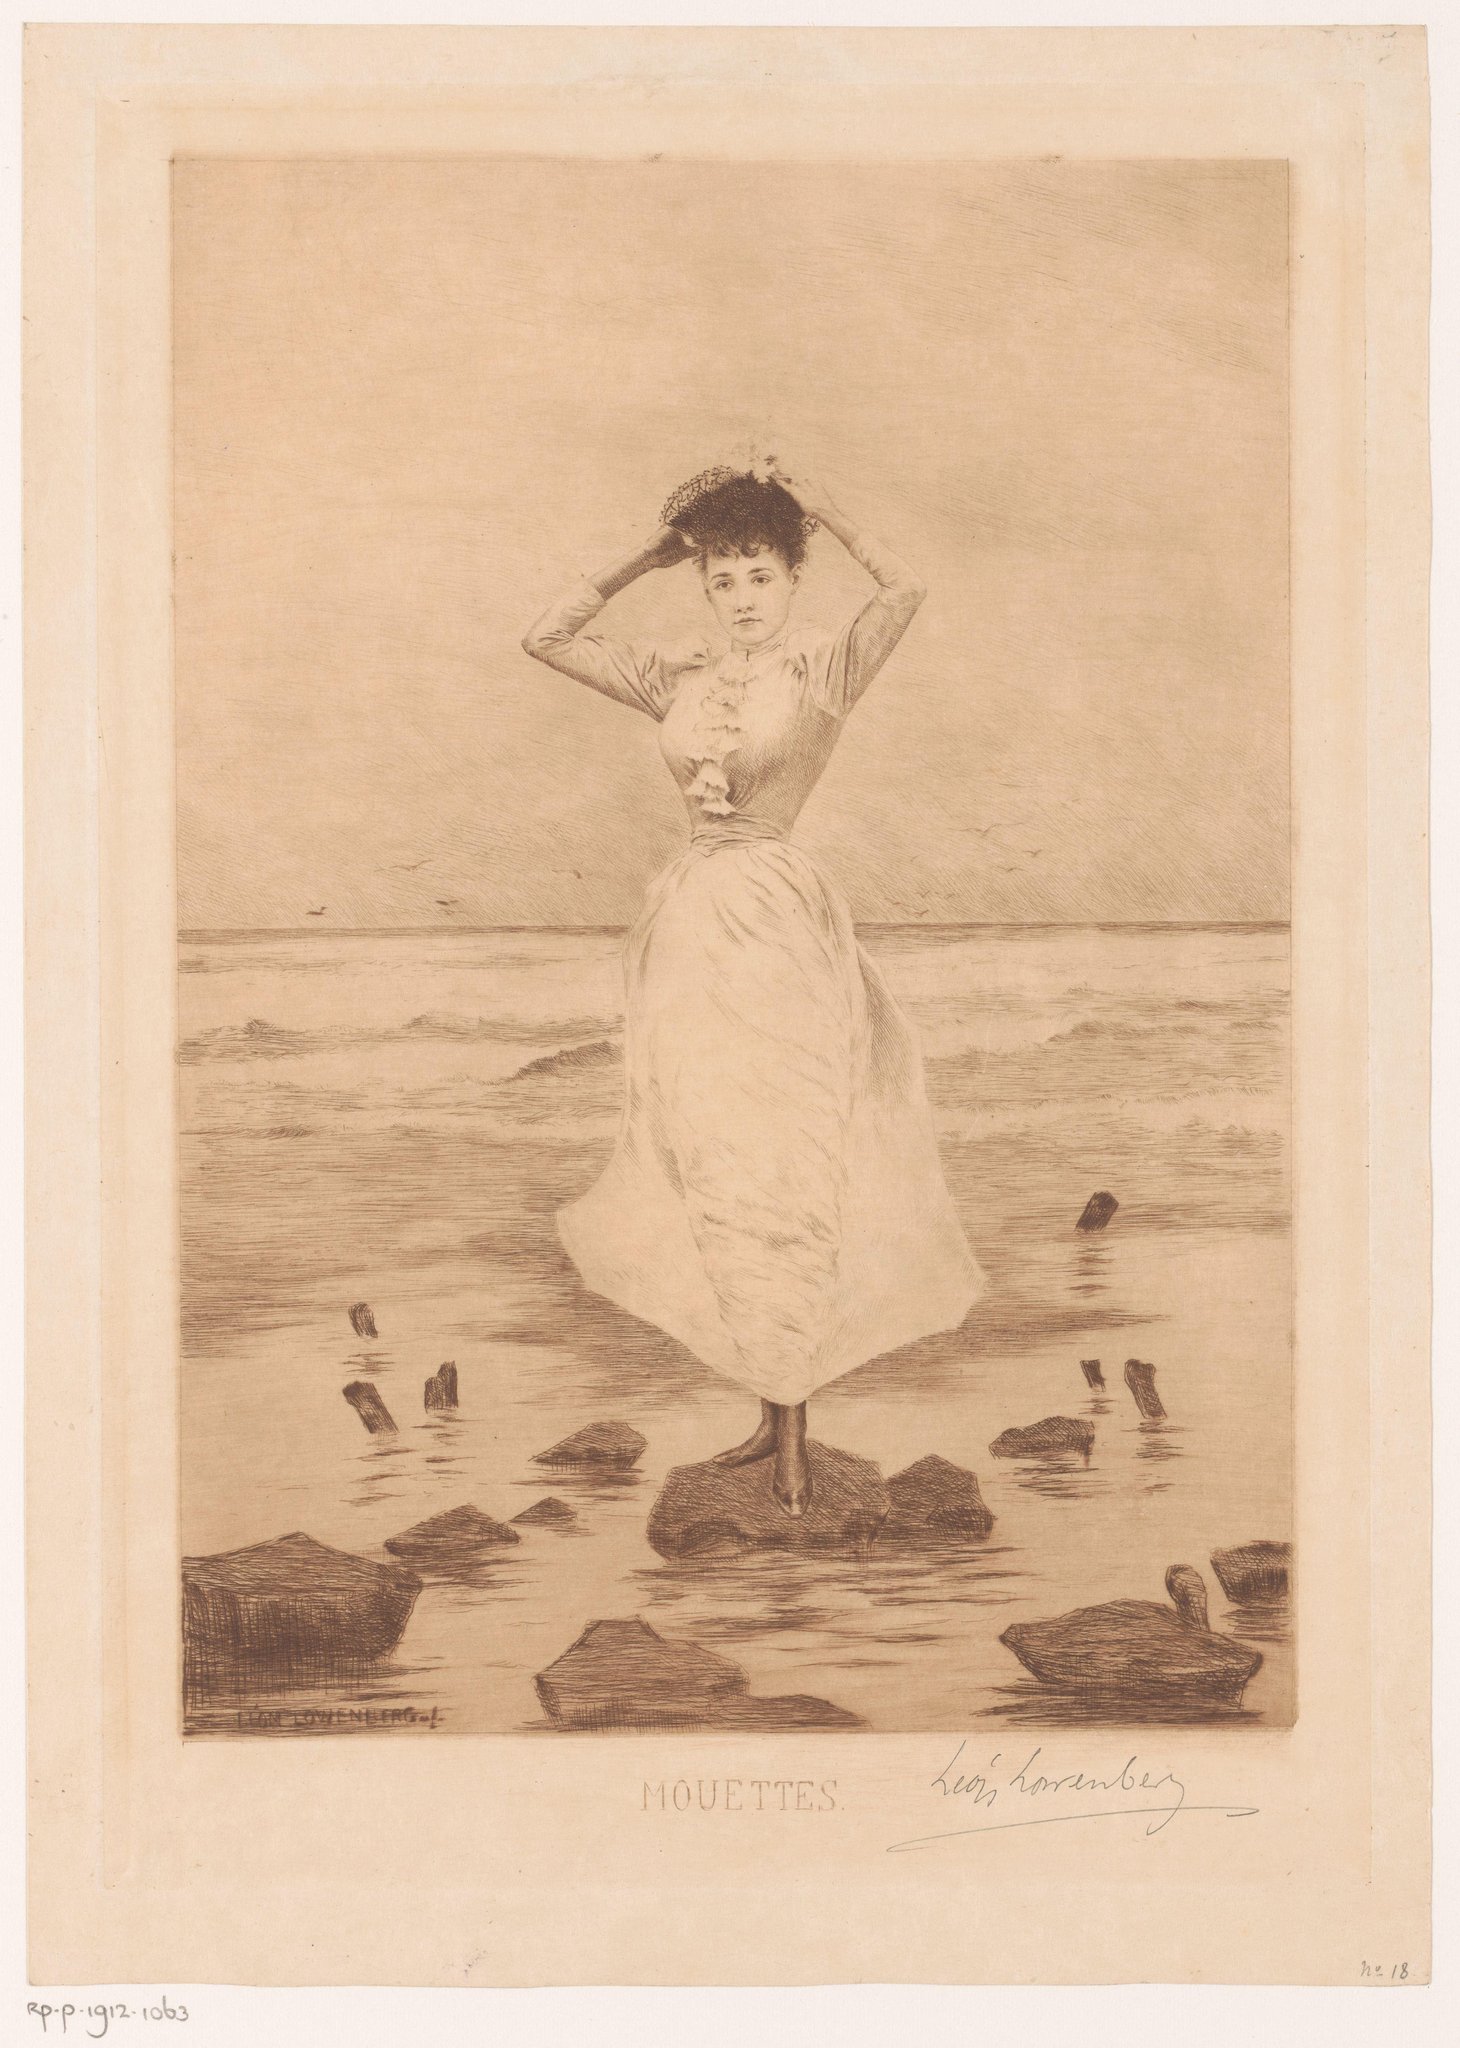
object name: print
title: Mouettes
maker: léon lowenberg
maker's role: print maker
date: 1875-1912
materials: paper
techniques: drypoint, etching, intaglio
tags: surf, breakers (+ landscape with figures, staffage)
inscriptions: collector's mark: Lugt 2228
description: Geboorte- en sterfdatum van de prentmaker zijn onbekend. Daarom is voor de bepaling van de rechten van dit object gebruik gemaakt van de verwervingsdatum Rijksmuseum Amsterdam.